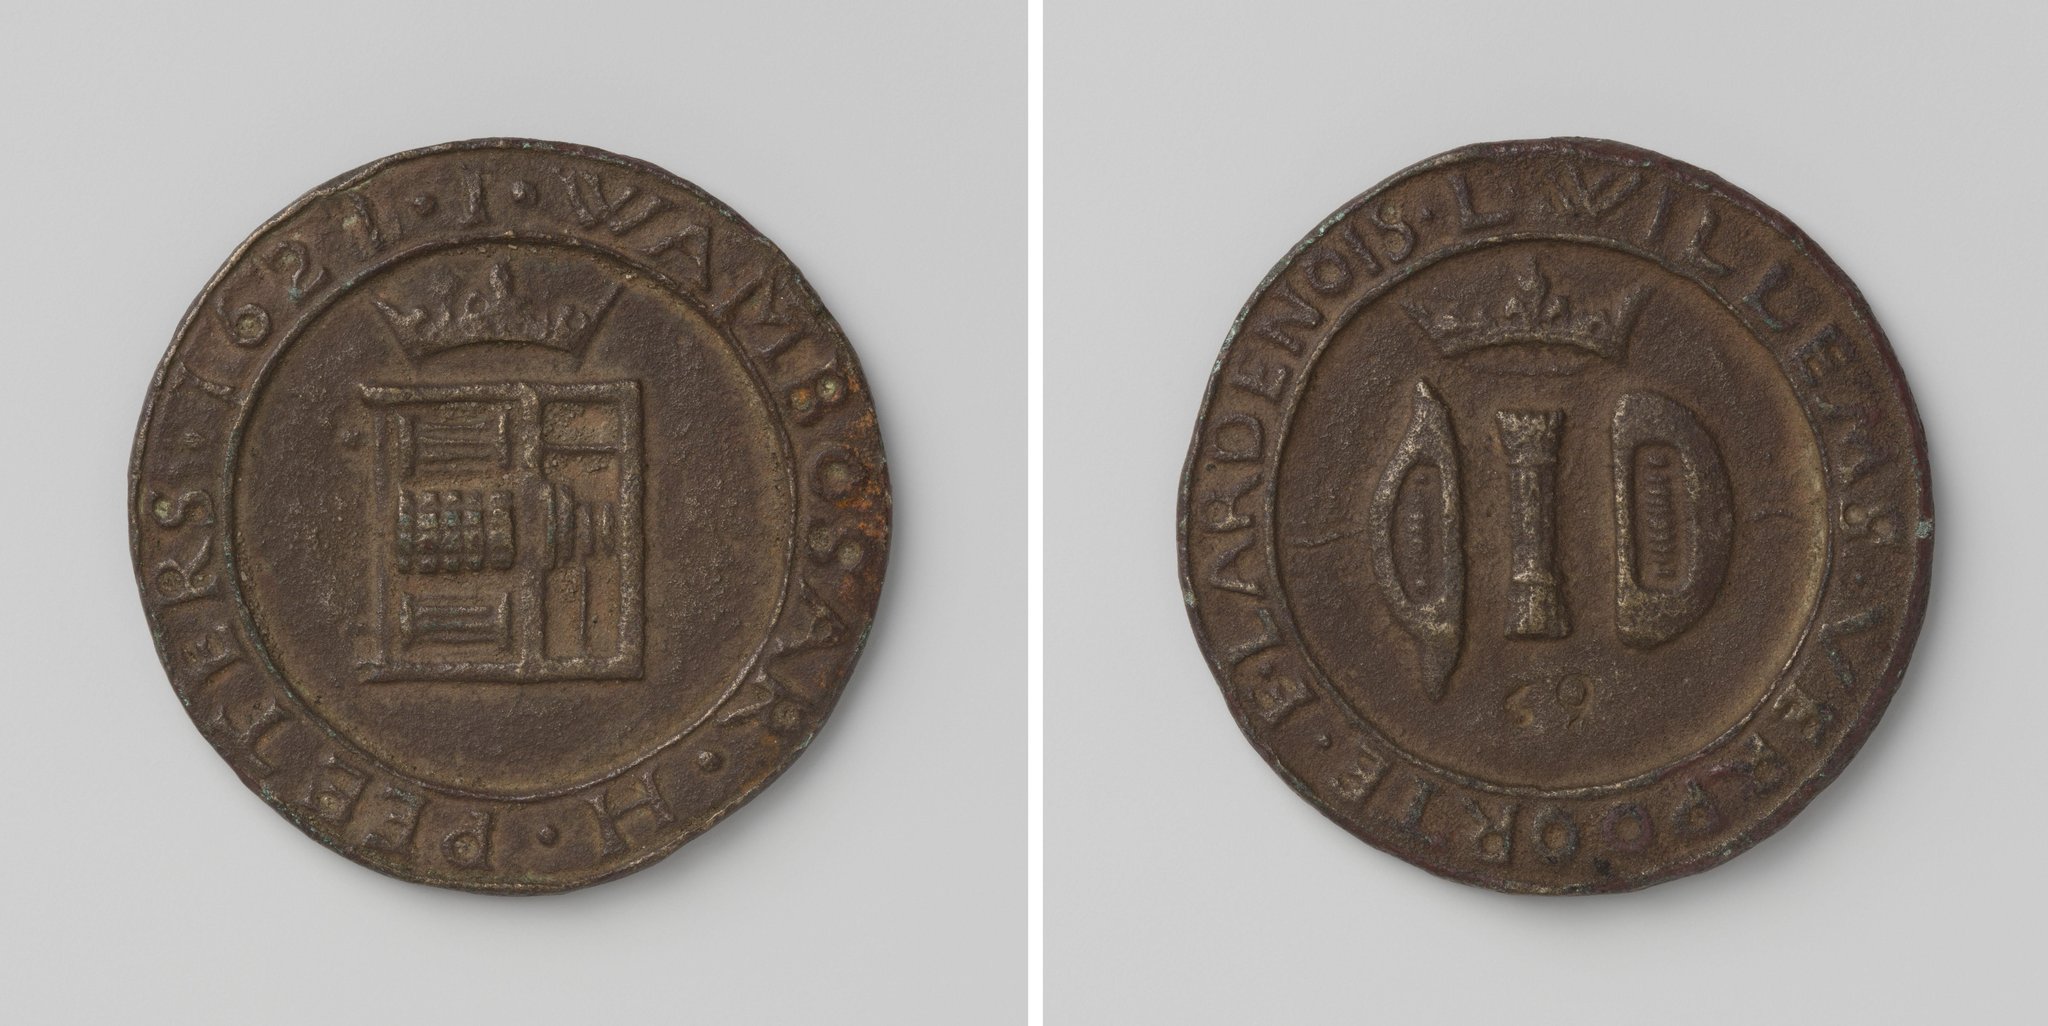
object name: medal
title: Zijdeverversgilde van Amsterdam, gildepenning met no. 69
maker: Anonymous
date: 1621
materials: brass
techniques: casting, engraving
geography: amsterdam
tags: amsterdam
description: Messing penning. Voorzijde: gekroonde linnenpers binnen omschrift. Keerzijde: drie instrumenten van linnenwevers boven cijfer 69 binnen omschrift